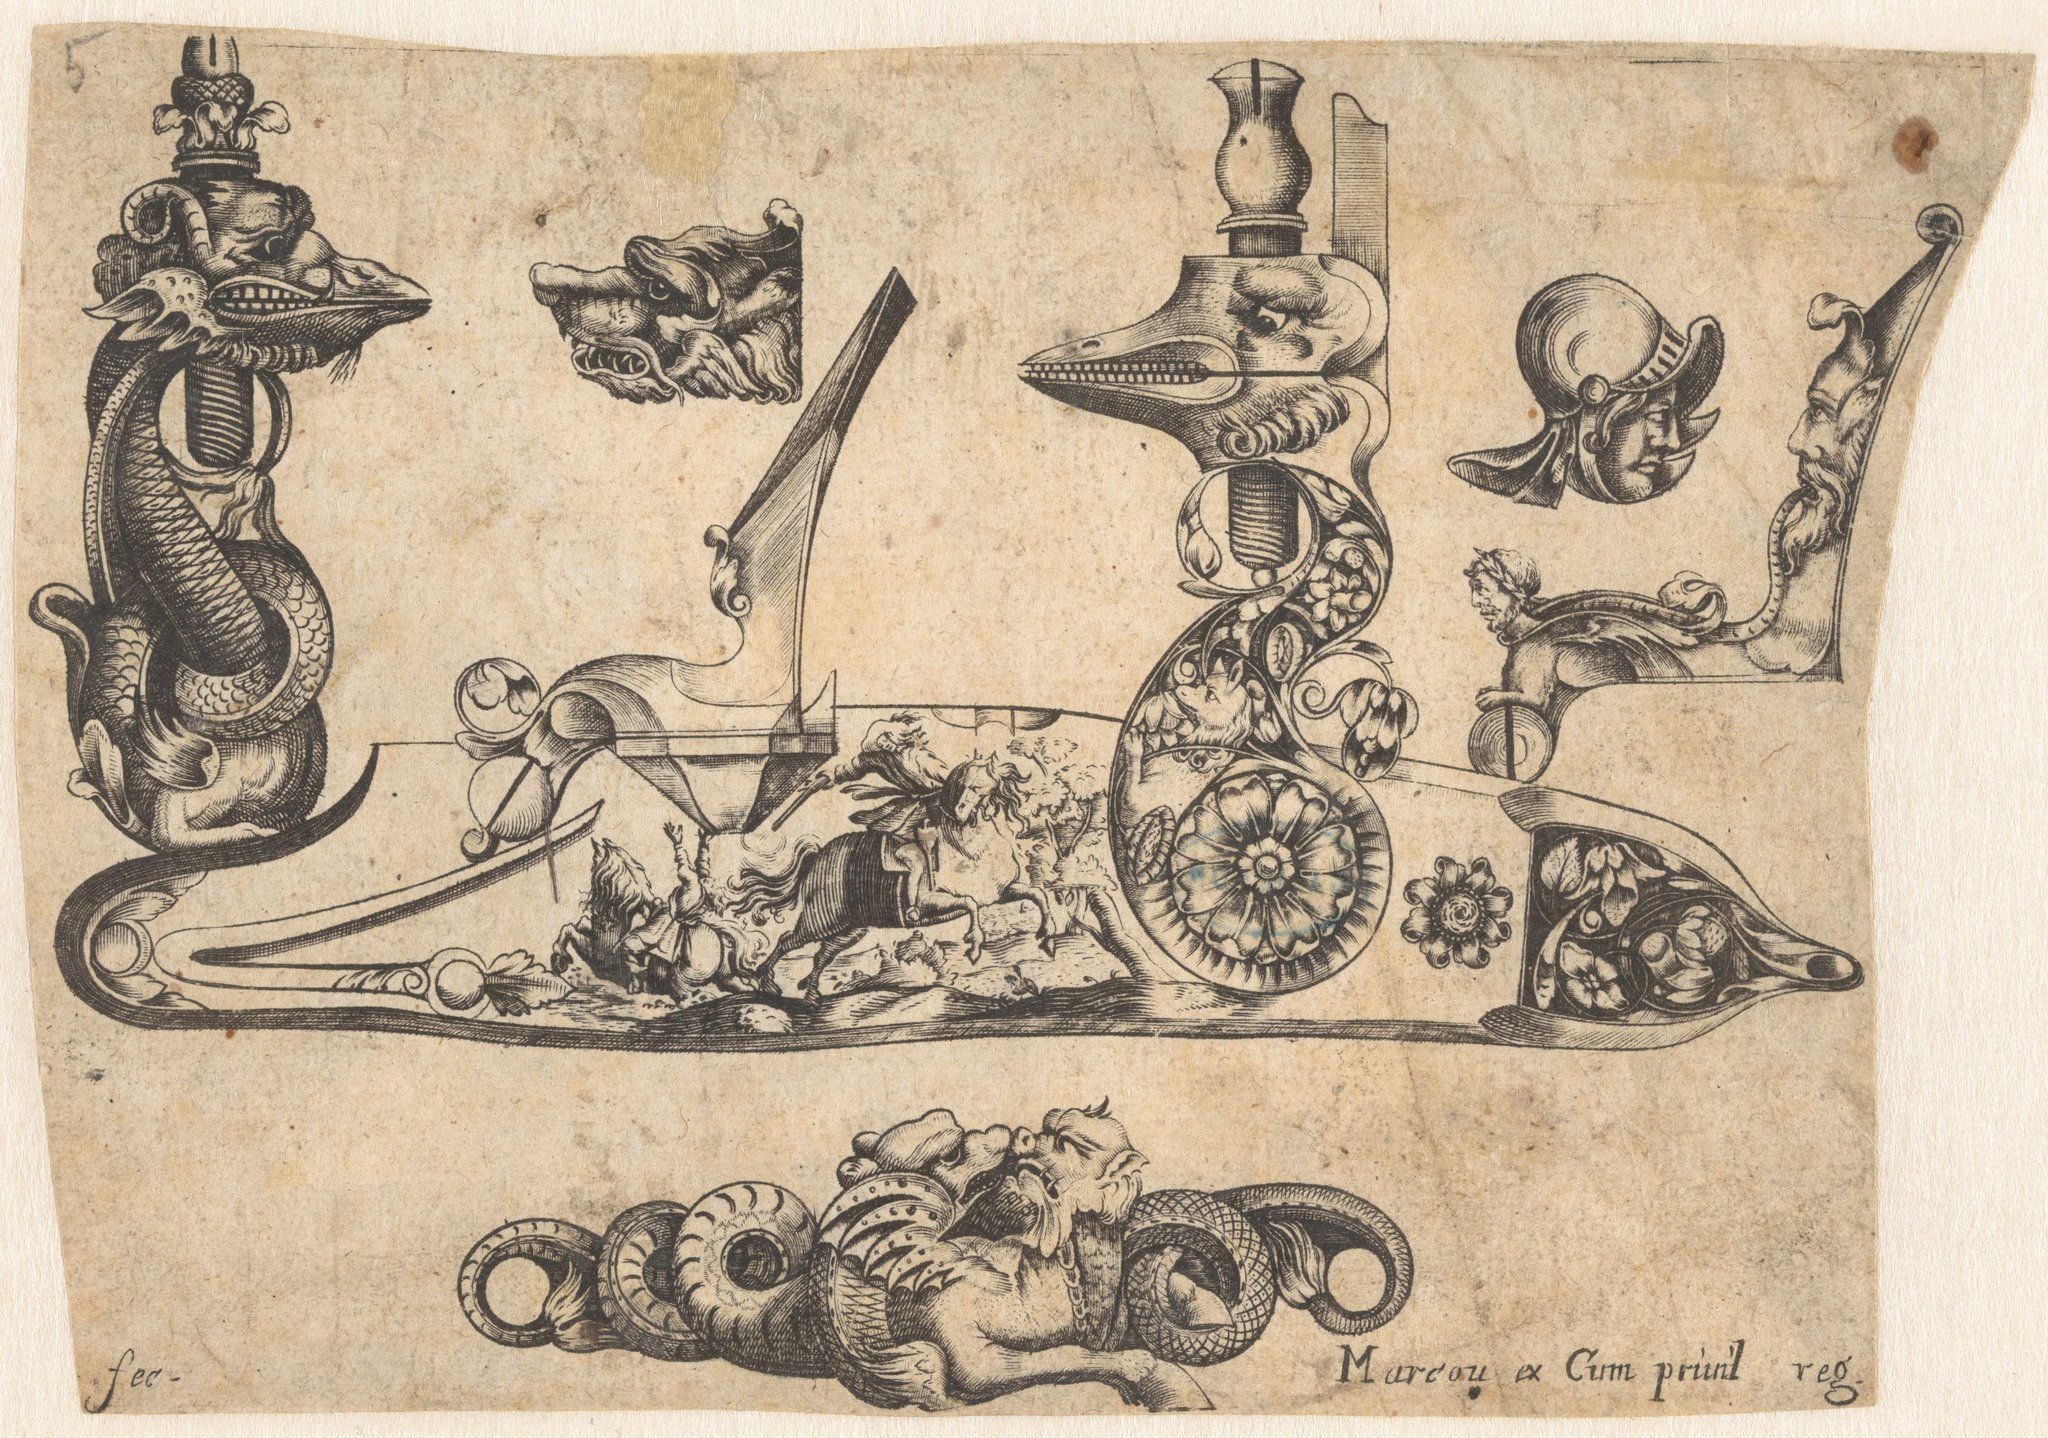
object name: print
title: Ornamenteel ontwerp voor geweer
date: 1657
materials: paper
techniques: engraving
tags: ornaments ~ art, armour, fighting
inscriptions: collector's mark: Lugt 1058, signature: ‘Marcou ex Cum privil reg.’, collector's mark: Lugt 2760, signature: ‘fec.’, collector's mark: Lugt 2228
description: Ontwerp voor geweeronderdelen versierd met figuratieve vechtscènes, militaire trofeeën, bloemen en mythologische wezens. Onderdeel van een serie.